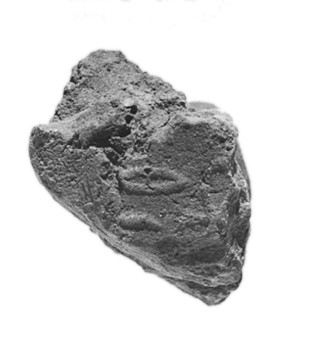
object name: sealing, administrative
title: Administrative Seal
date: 1981-1640 BCE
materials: clay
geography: egypt